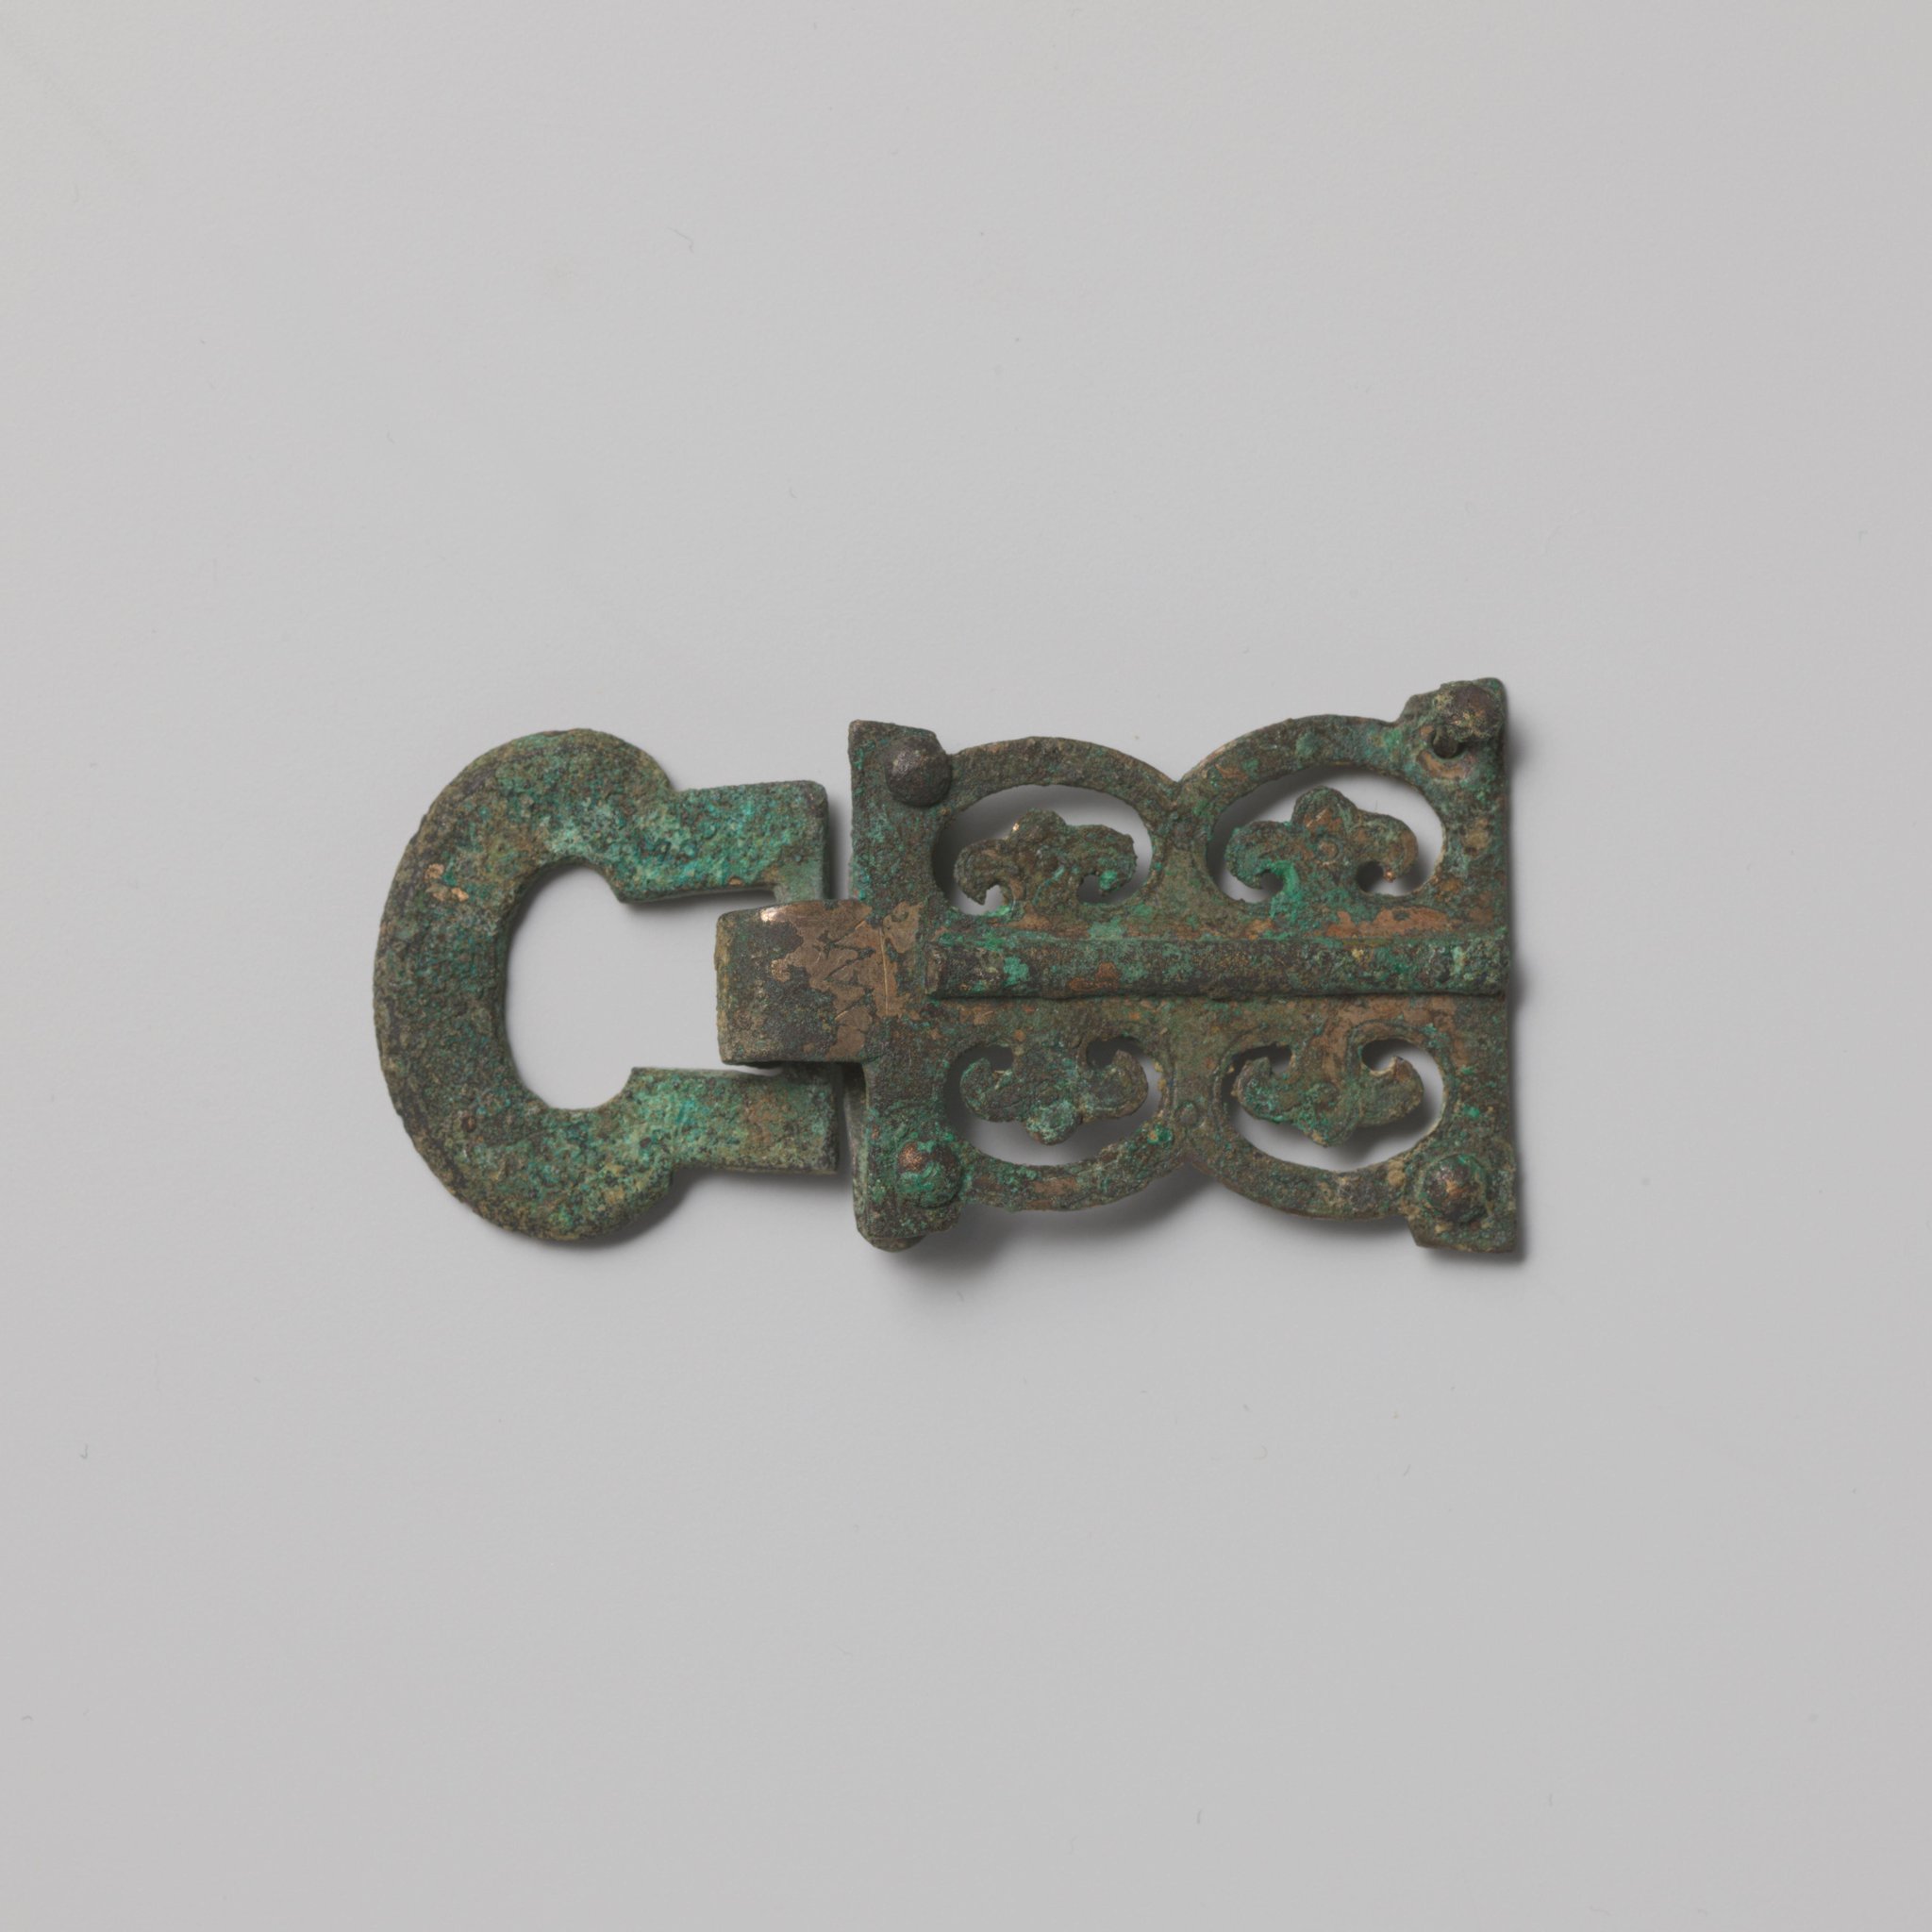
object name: buckle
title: Gesp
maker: Anonymous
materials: bronze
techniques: gilding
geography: china